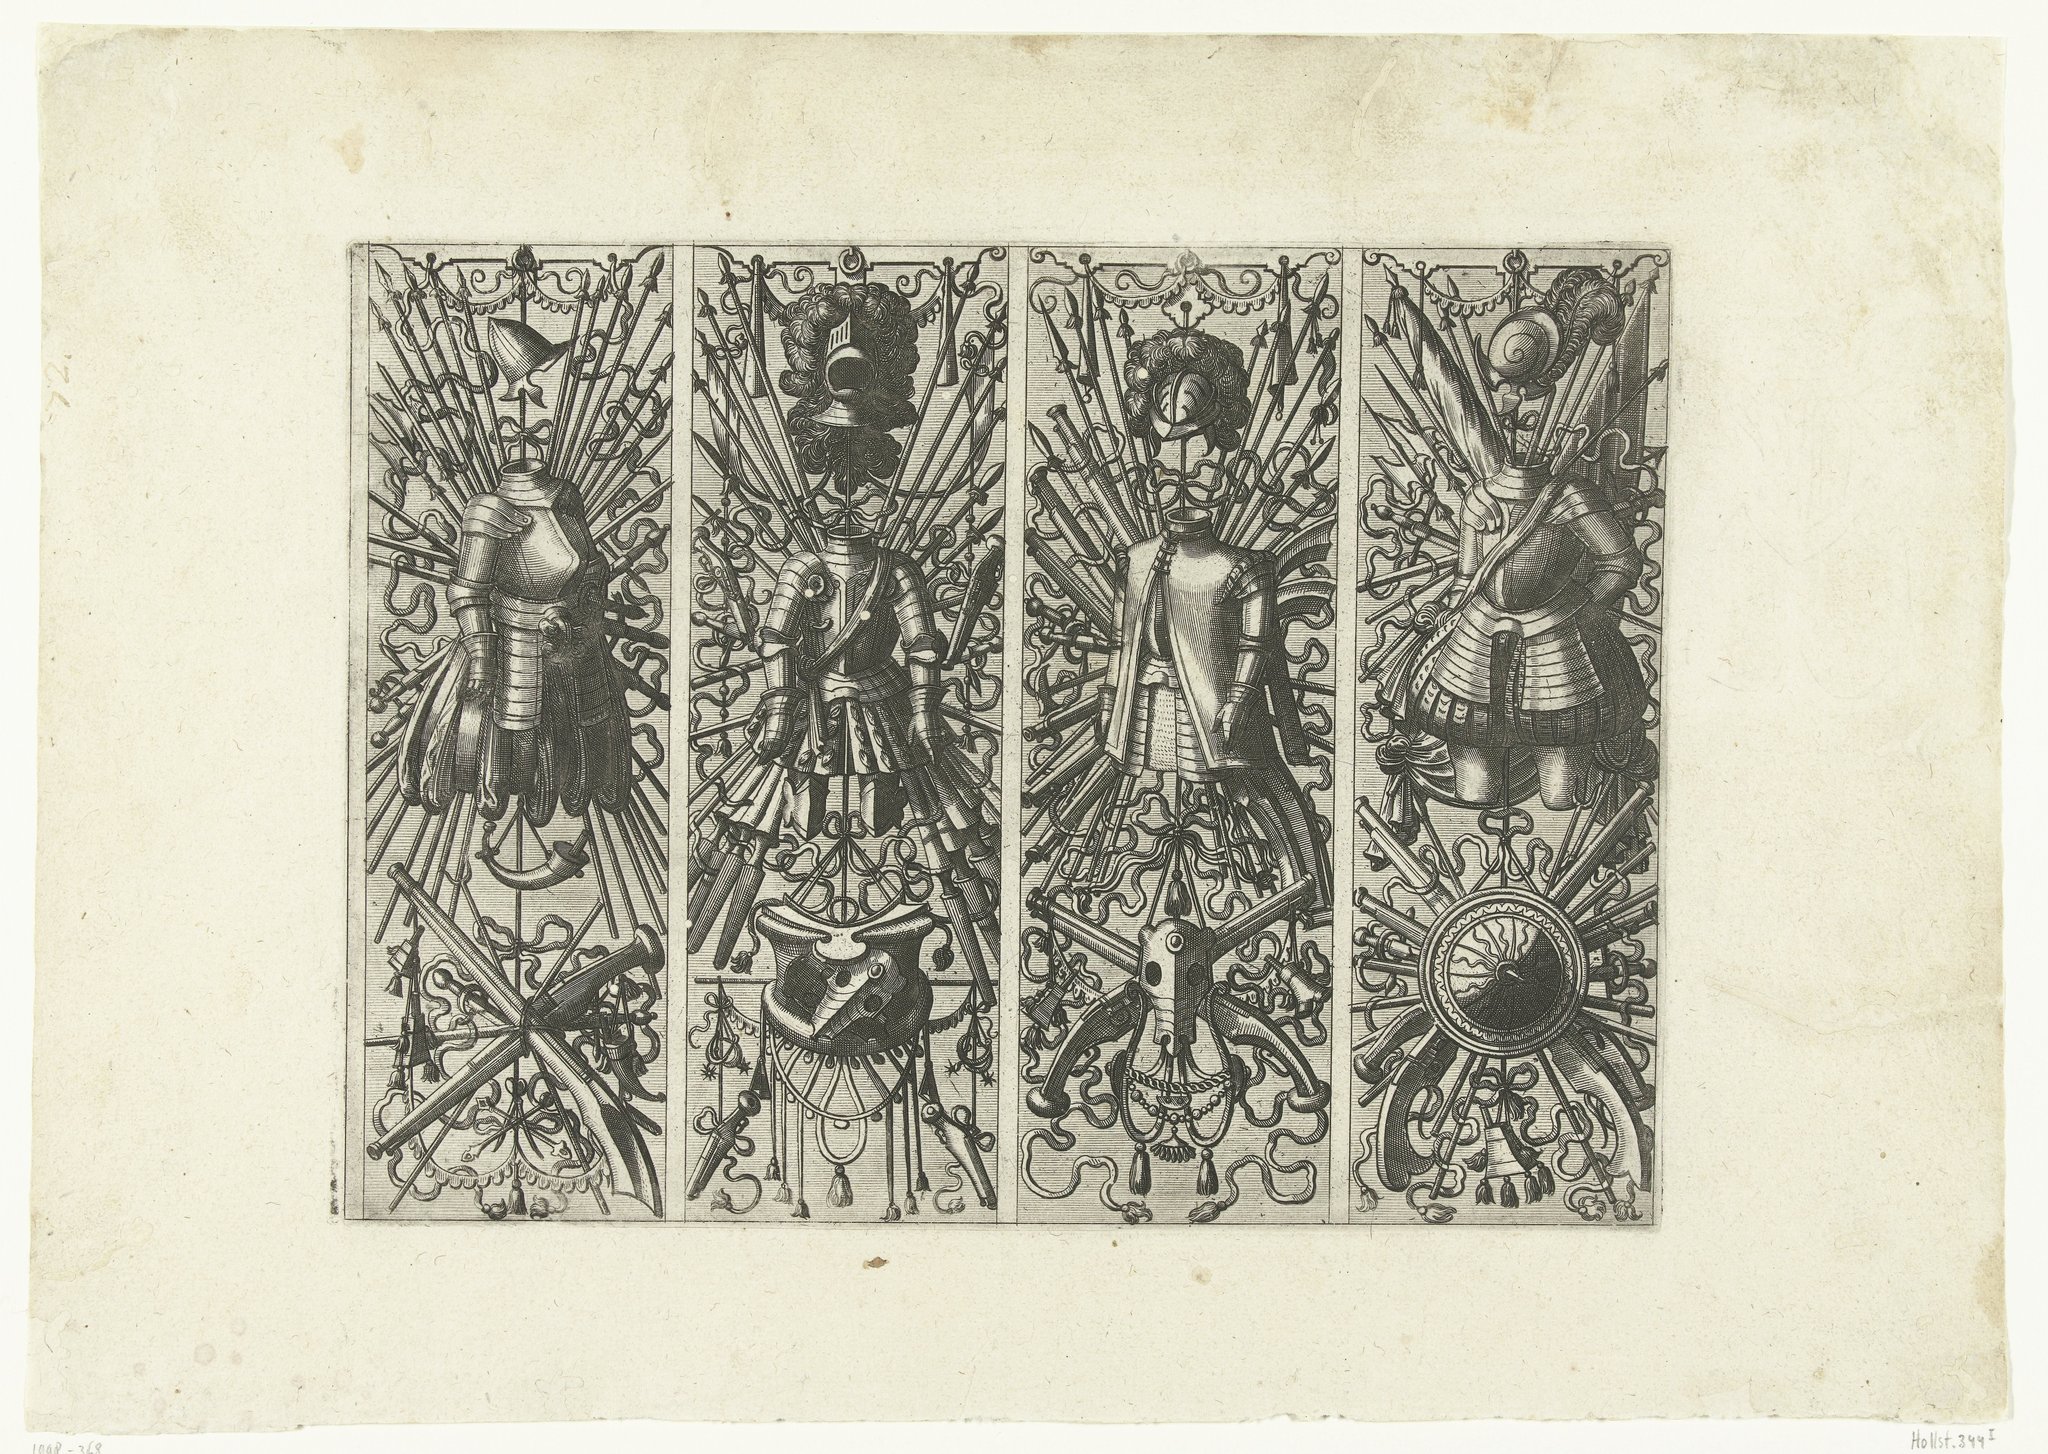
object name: print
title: Vier verticale trofeeën met harnassen en wapens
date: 1572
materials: paper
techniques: etching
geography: netherlands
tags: trophy, i.e.: decorative arrangement of symbolic or typical objects ~ ornament, armour, weapons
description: Vier verticale trofeeën met harnassen, speren, lansen en geweren. Uit serie, bestaande uit een titelblad en 16 bladen.